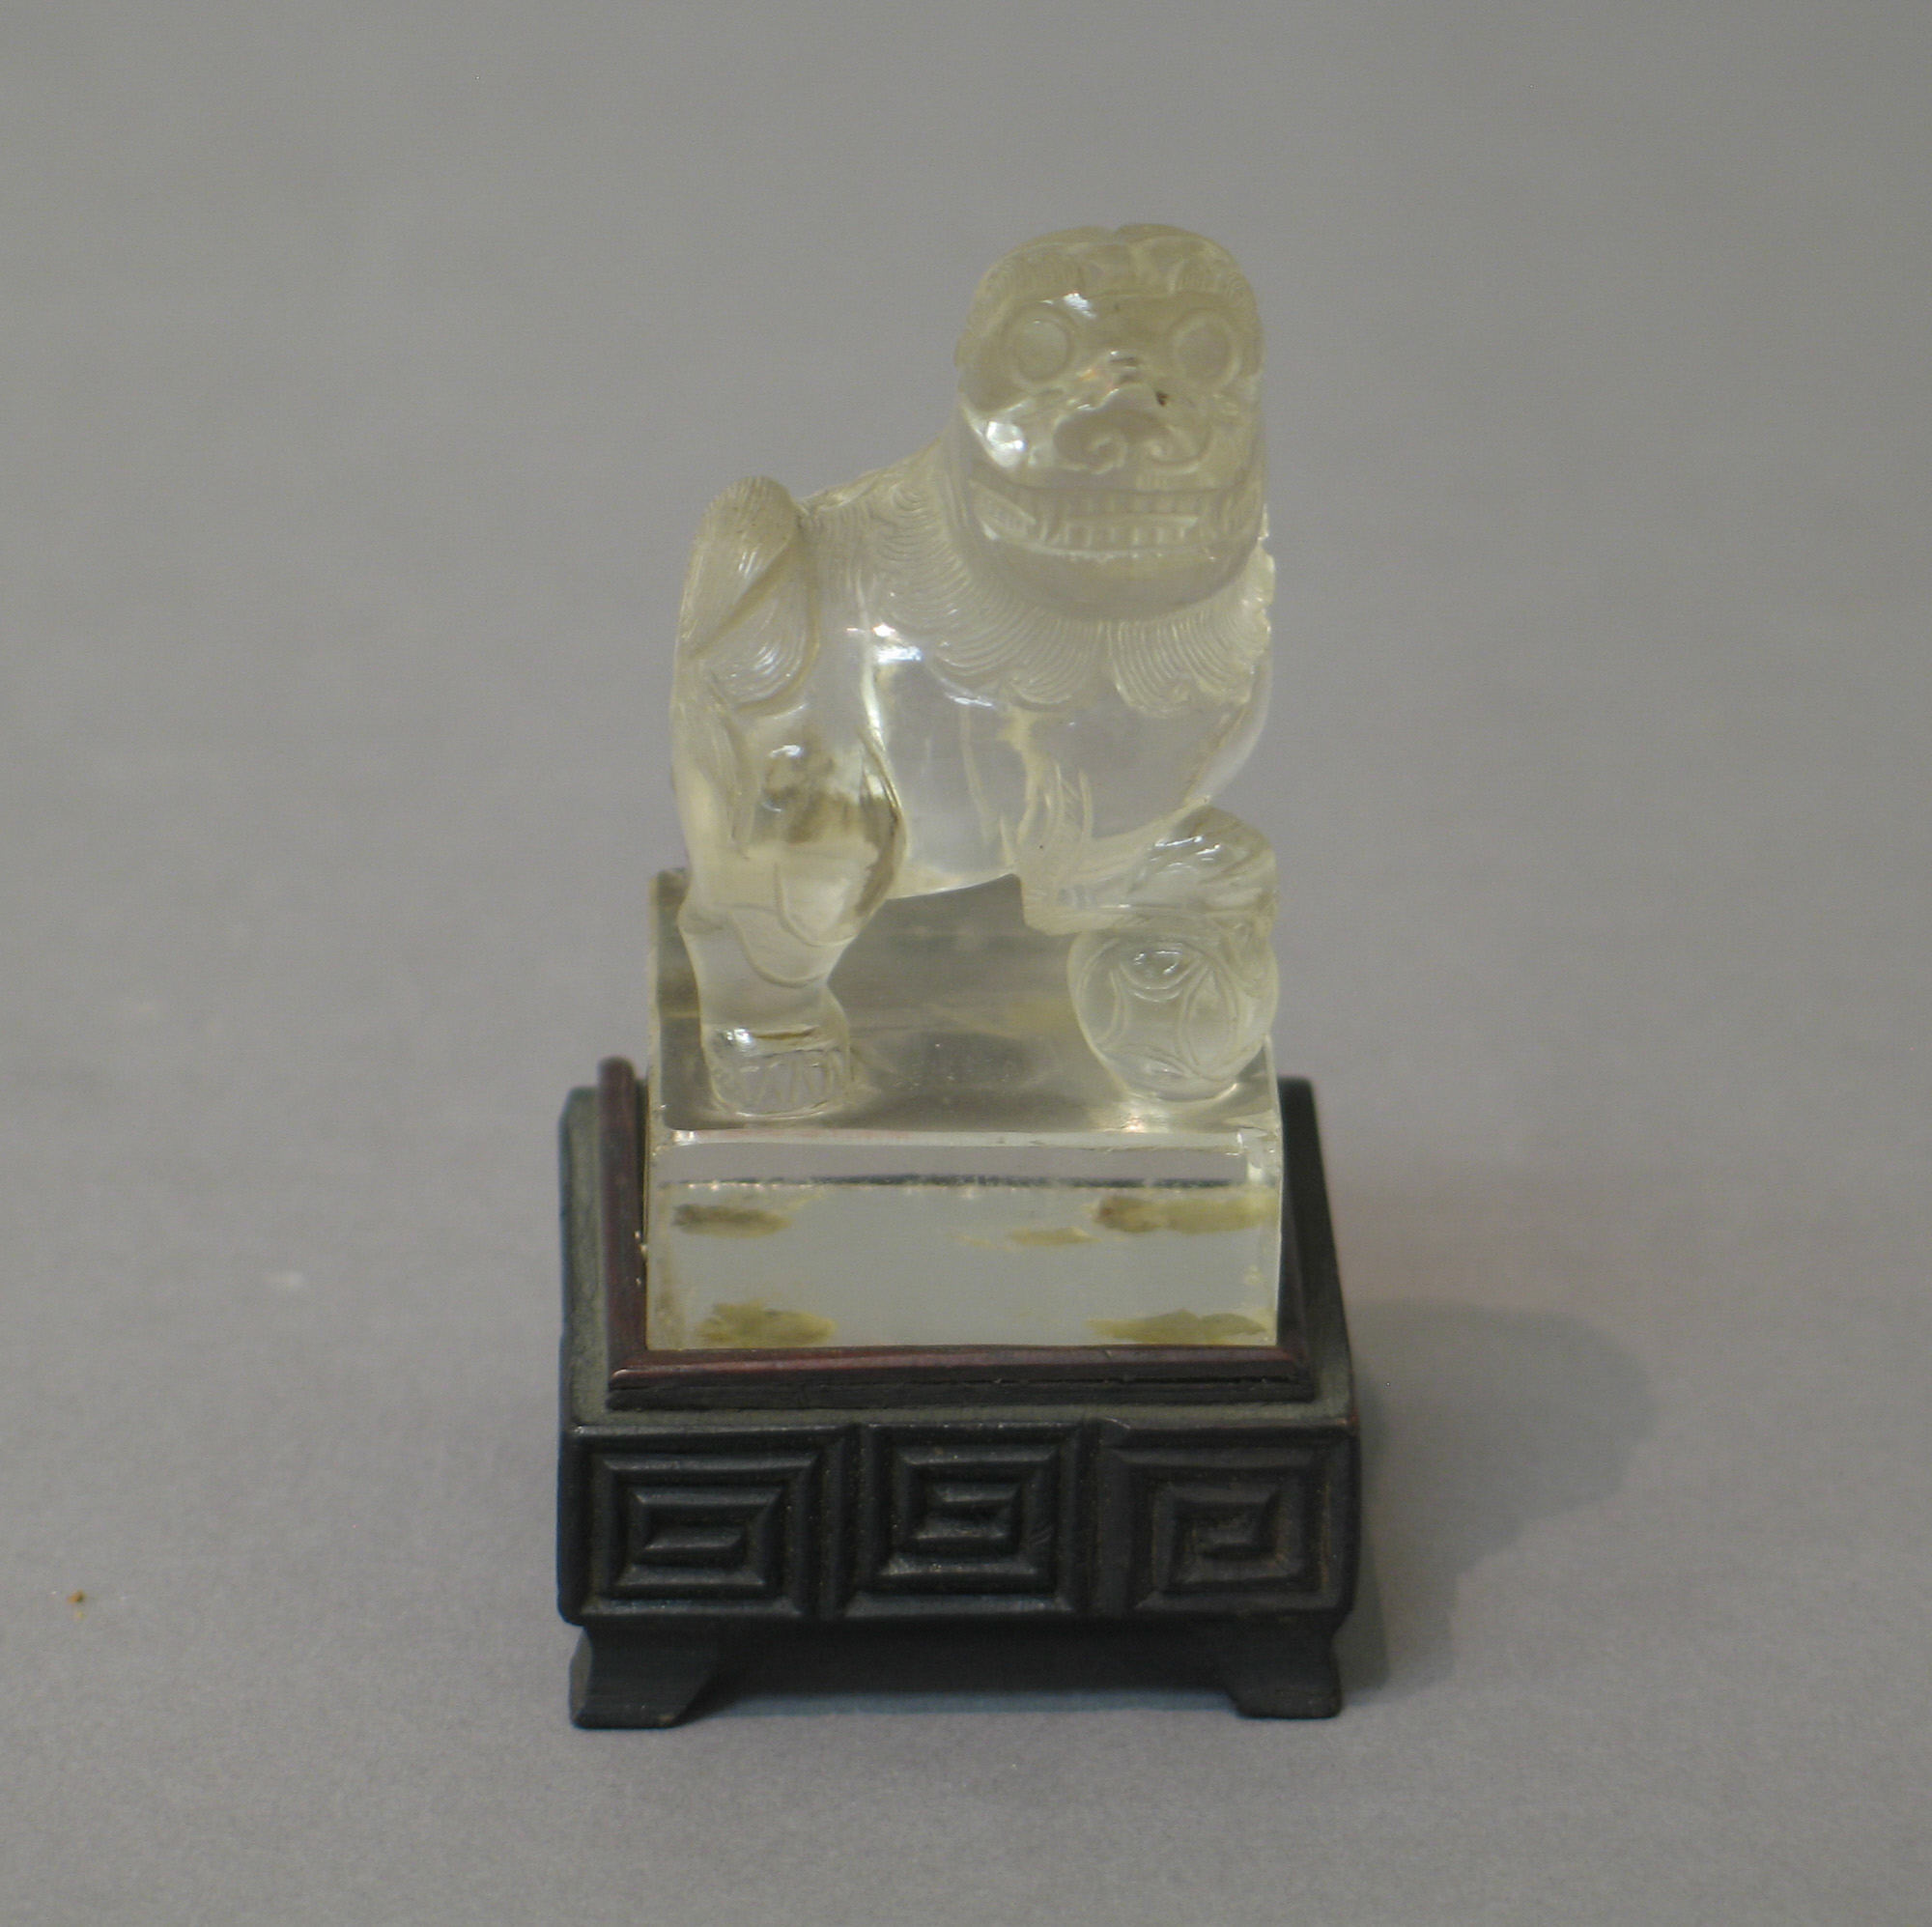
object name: paperweight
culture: chinese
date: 1701-1800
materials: quartz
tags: dogs